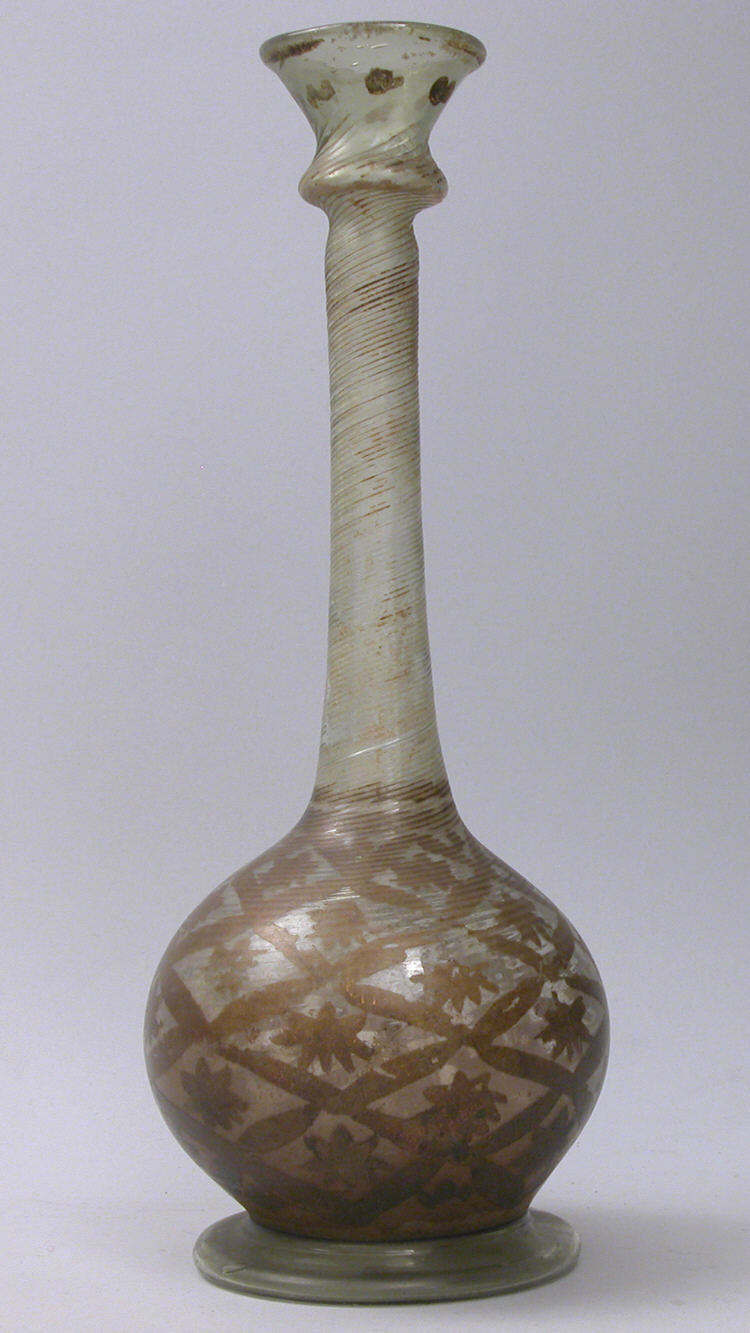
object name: bottle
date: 1701-1900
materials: glass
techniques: glassblowing, painting, tooling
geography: iran